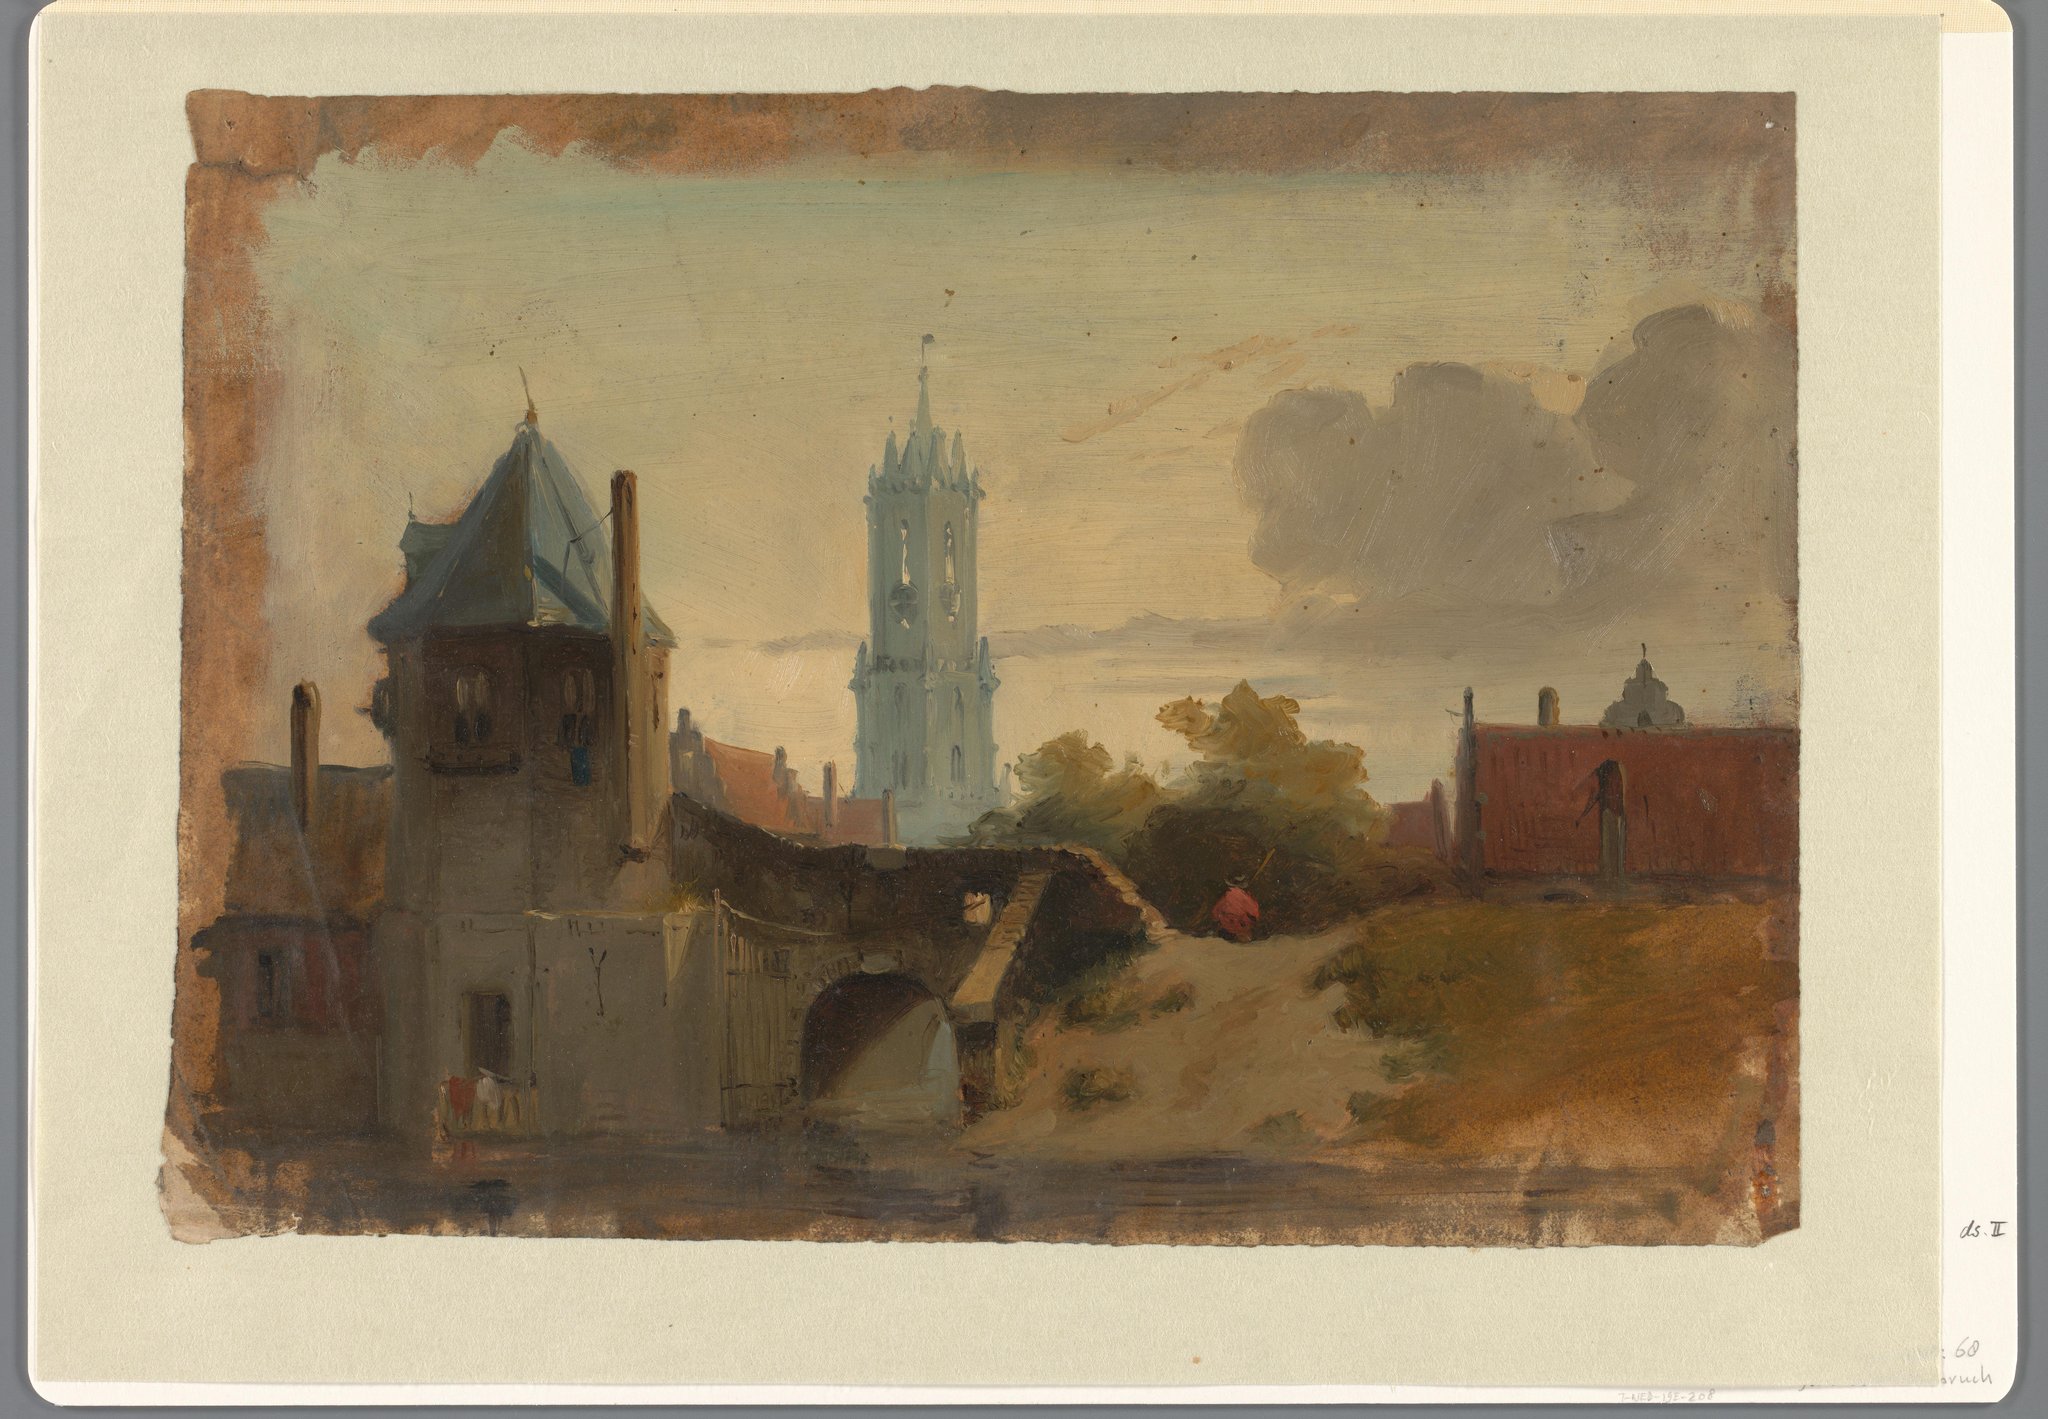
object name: drawing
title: Gezicht op Delft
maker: jan weissenbruch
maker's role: painter, print maker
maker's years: 1822-1880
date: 1832-1880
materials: oil, paper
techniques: brush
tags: prospect of city, town panorama, silhouette of city, delft